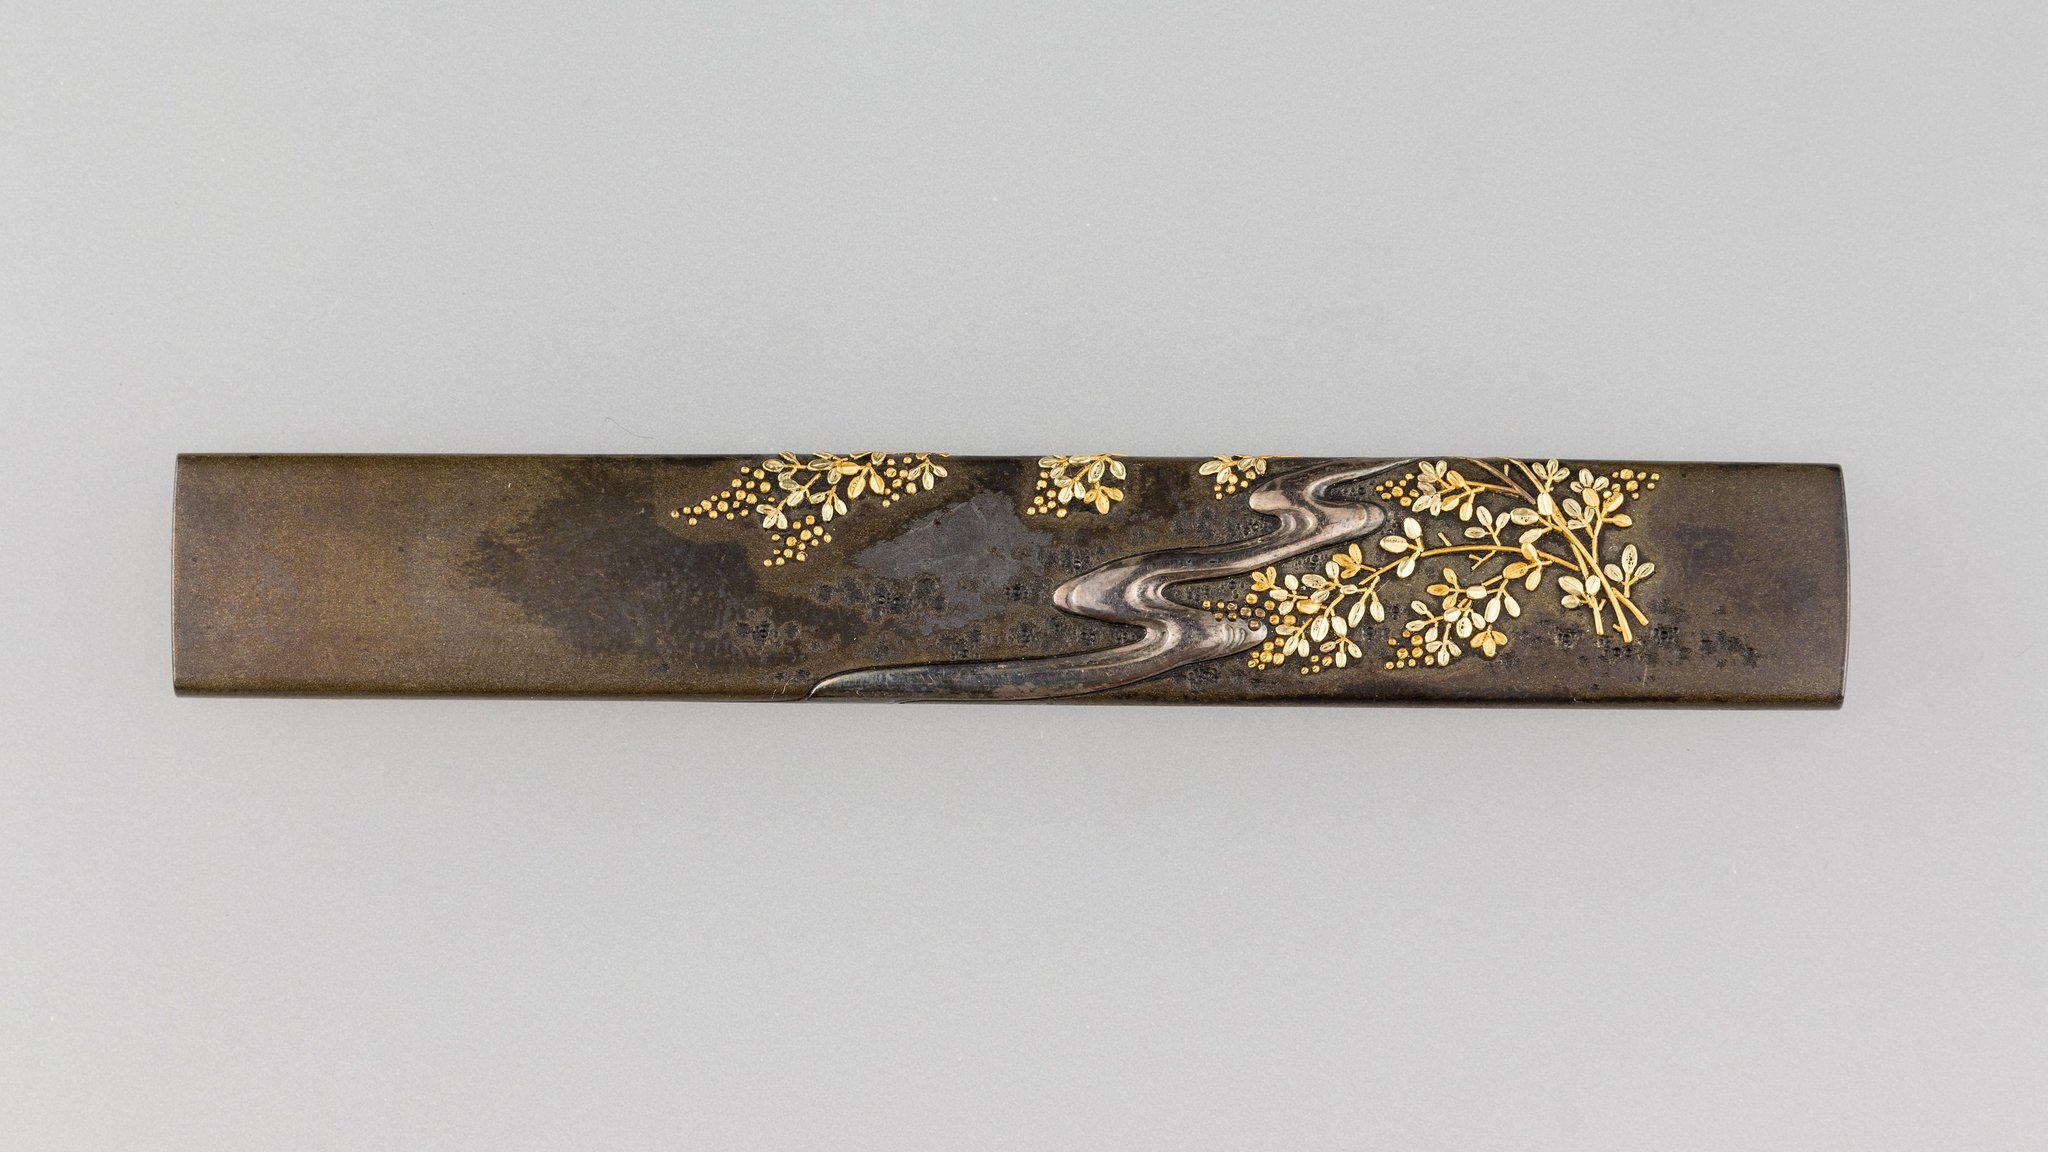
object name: knife handle kozuka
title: Knife Handle (Kozuka)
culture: japanese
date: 1701-1800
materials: gold alloy, silver alloy, gold, silver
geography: japan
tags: plants